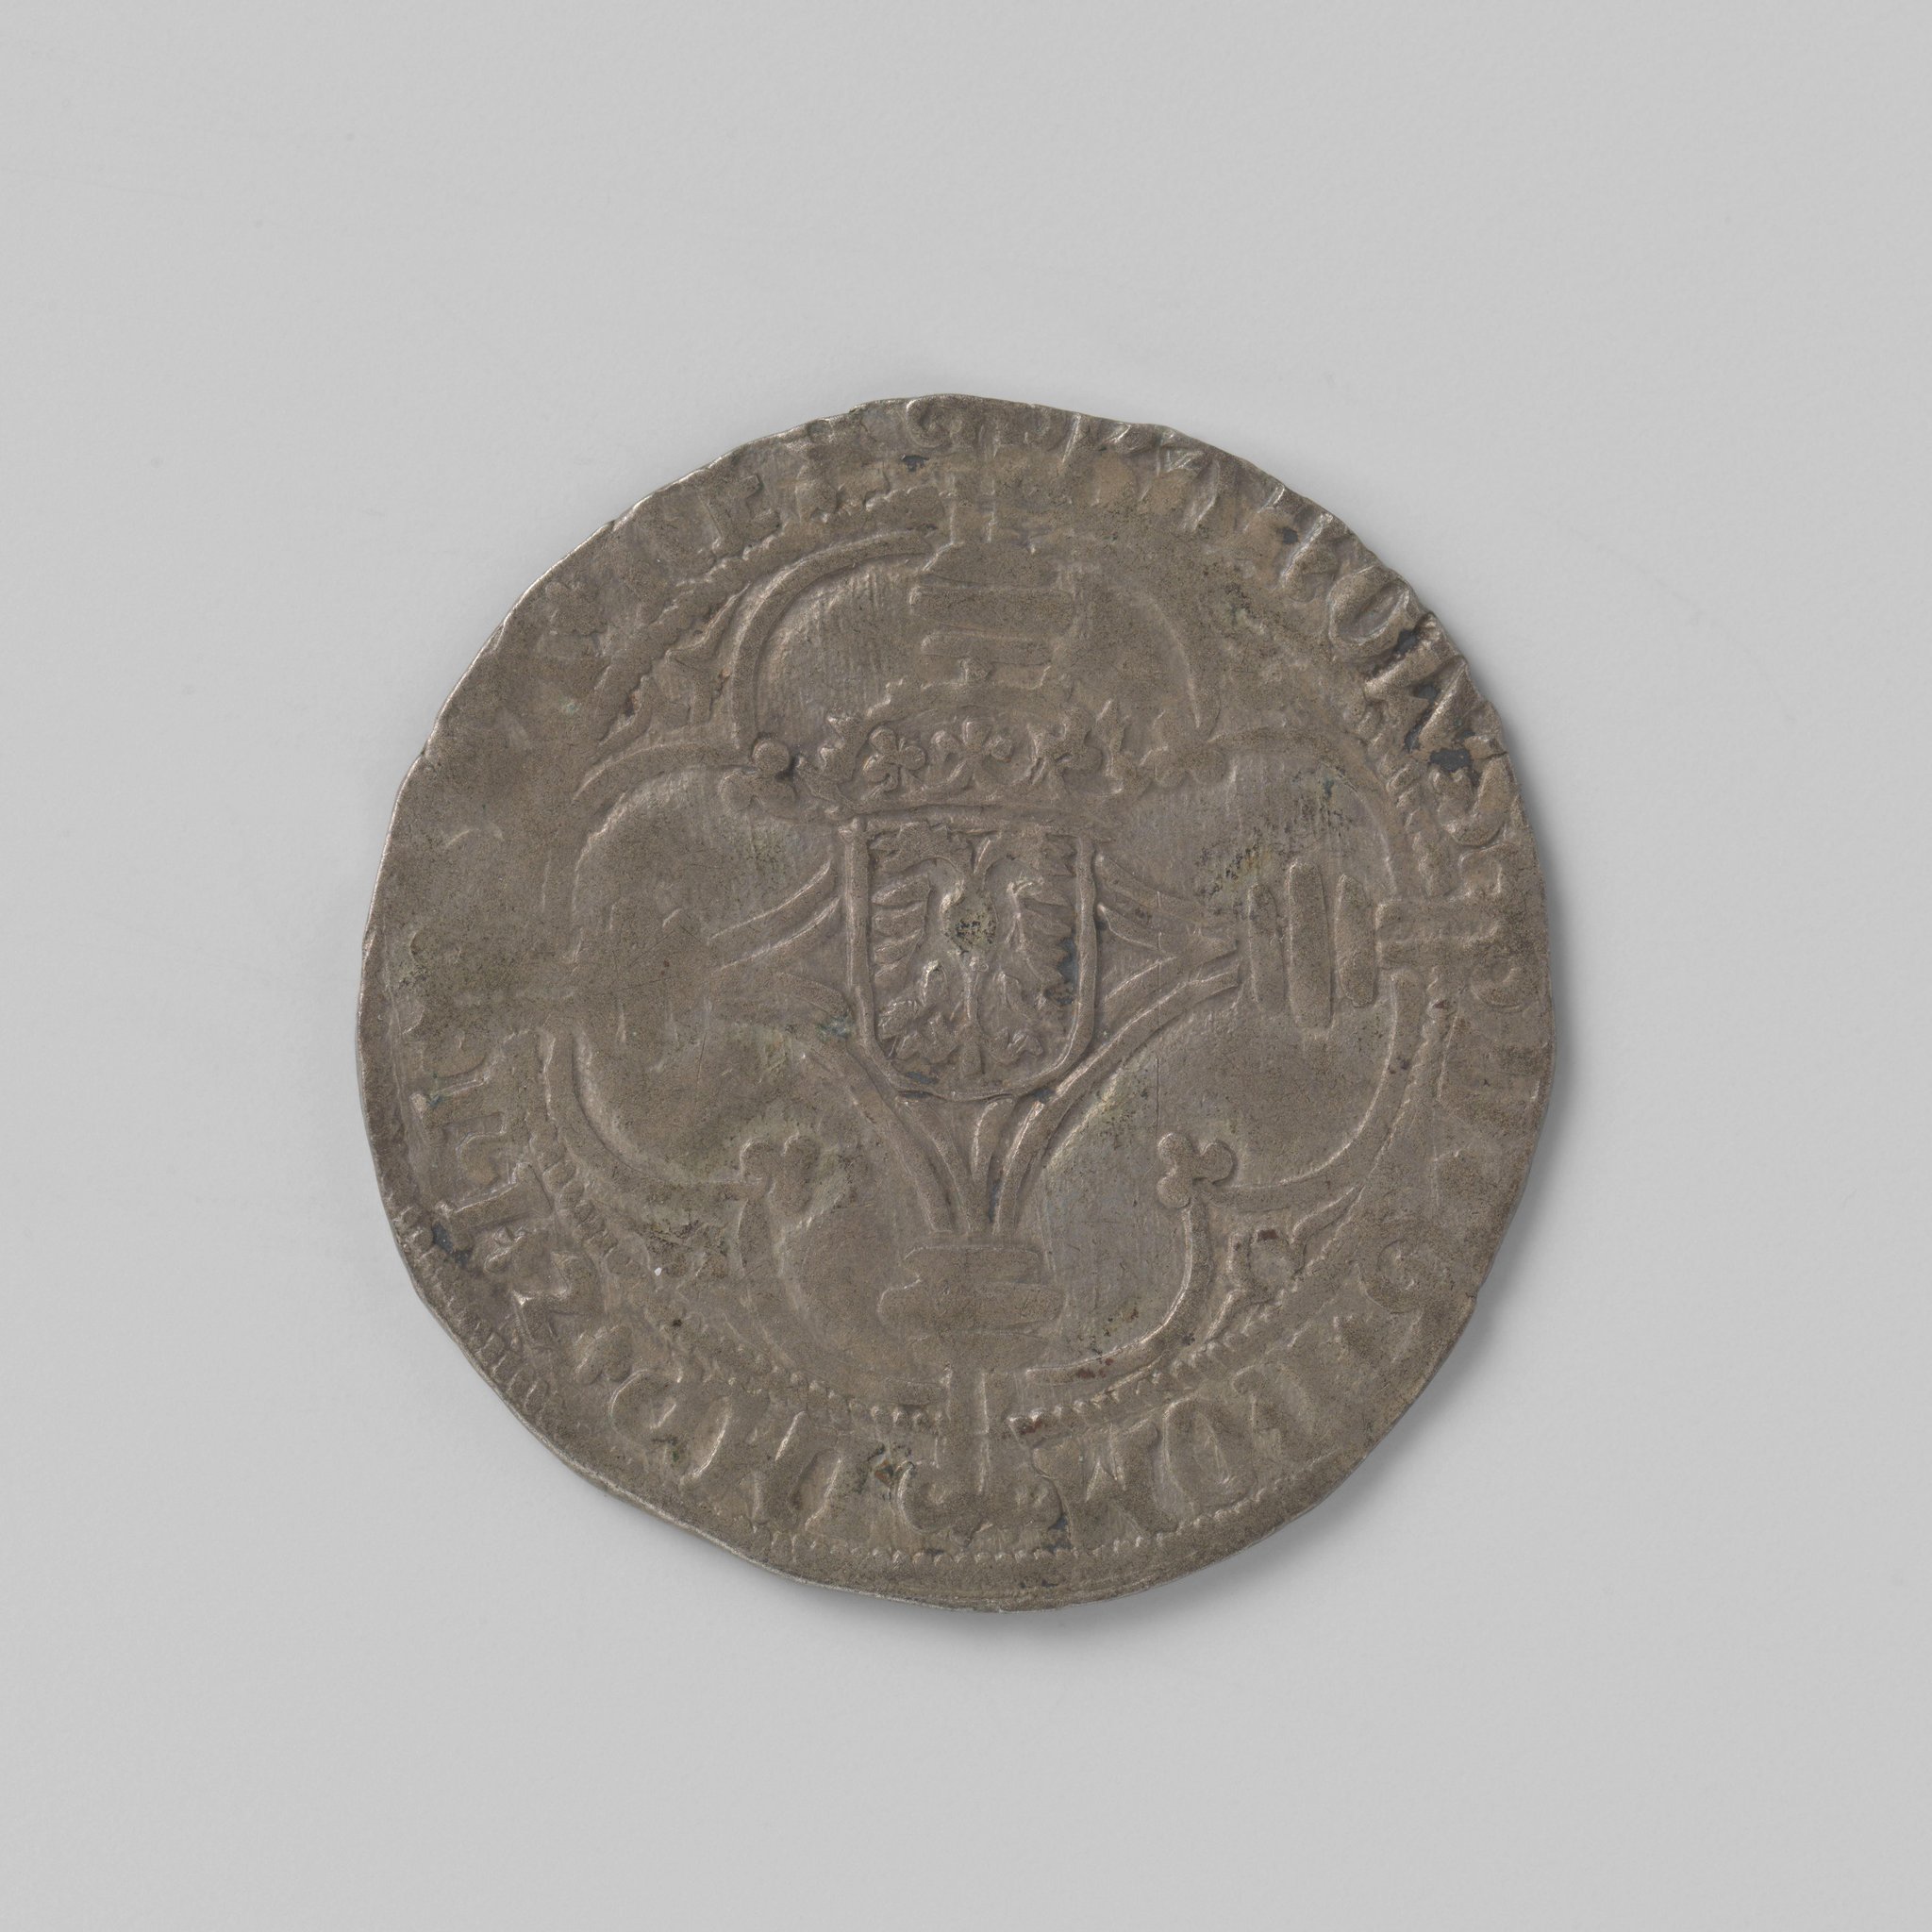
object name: coin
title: Hollandse stuiver van Karel V, 1506-1555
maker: charles v (holy roman emperor and king of spain)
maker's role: keizer, koning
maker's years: 1500-1558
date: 1521-1529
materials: silver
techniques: striking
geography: dordrecht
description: Zilveren munt. Voorzijde: op een vierpas lang versierd kruis, in hart gekroond wapenschild van het Heilige Roomse Rijk. Keerzijde: tussen twee gekruiste knoestige stokken gekroond wapenschild van Oostenrijk-Bourgondië. Initiaalteken: roosje.